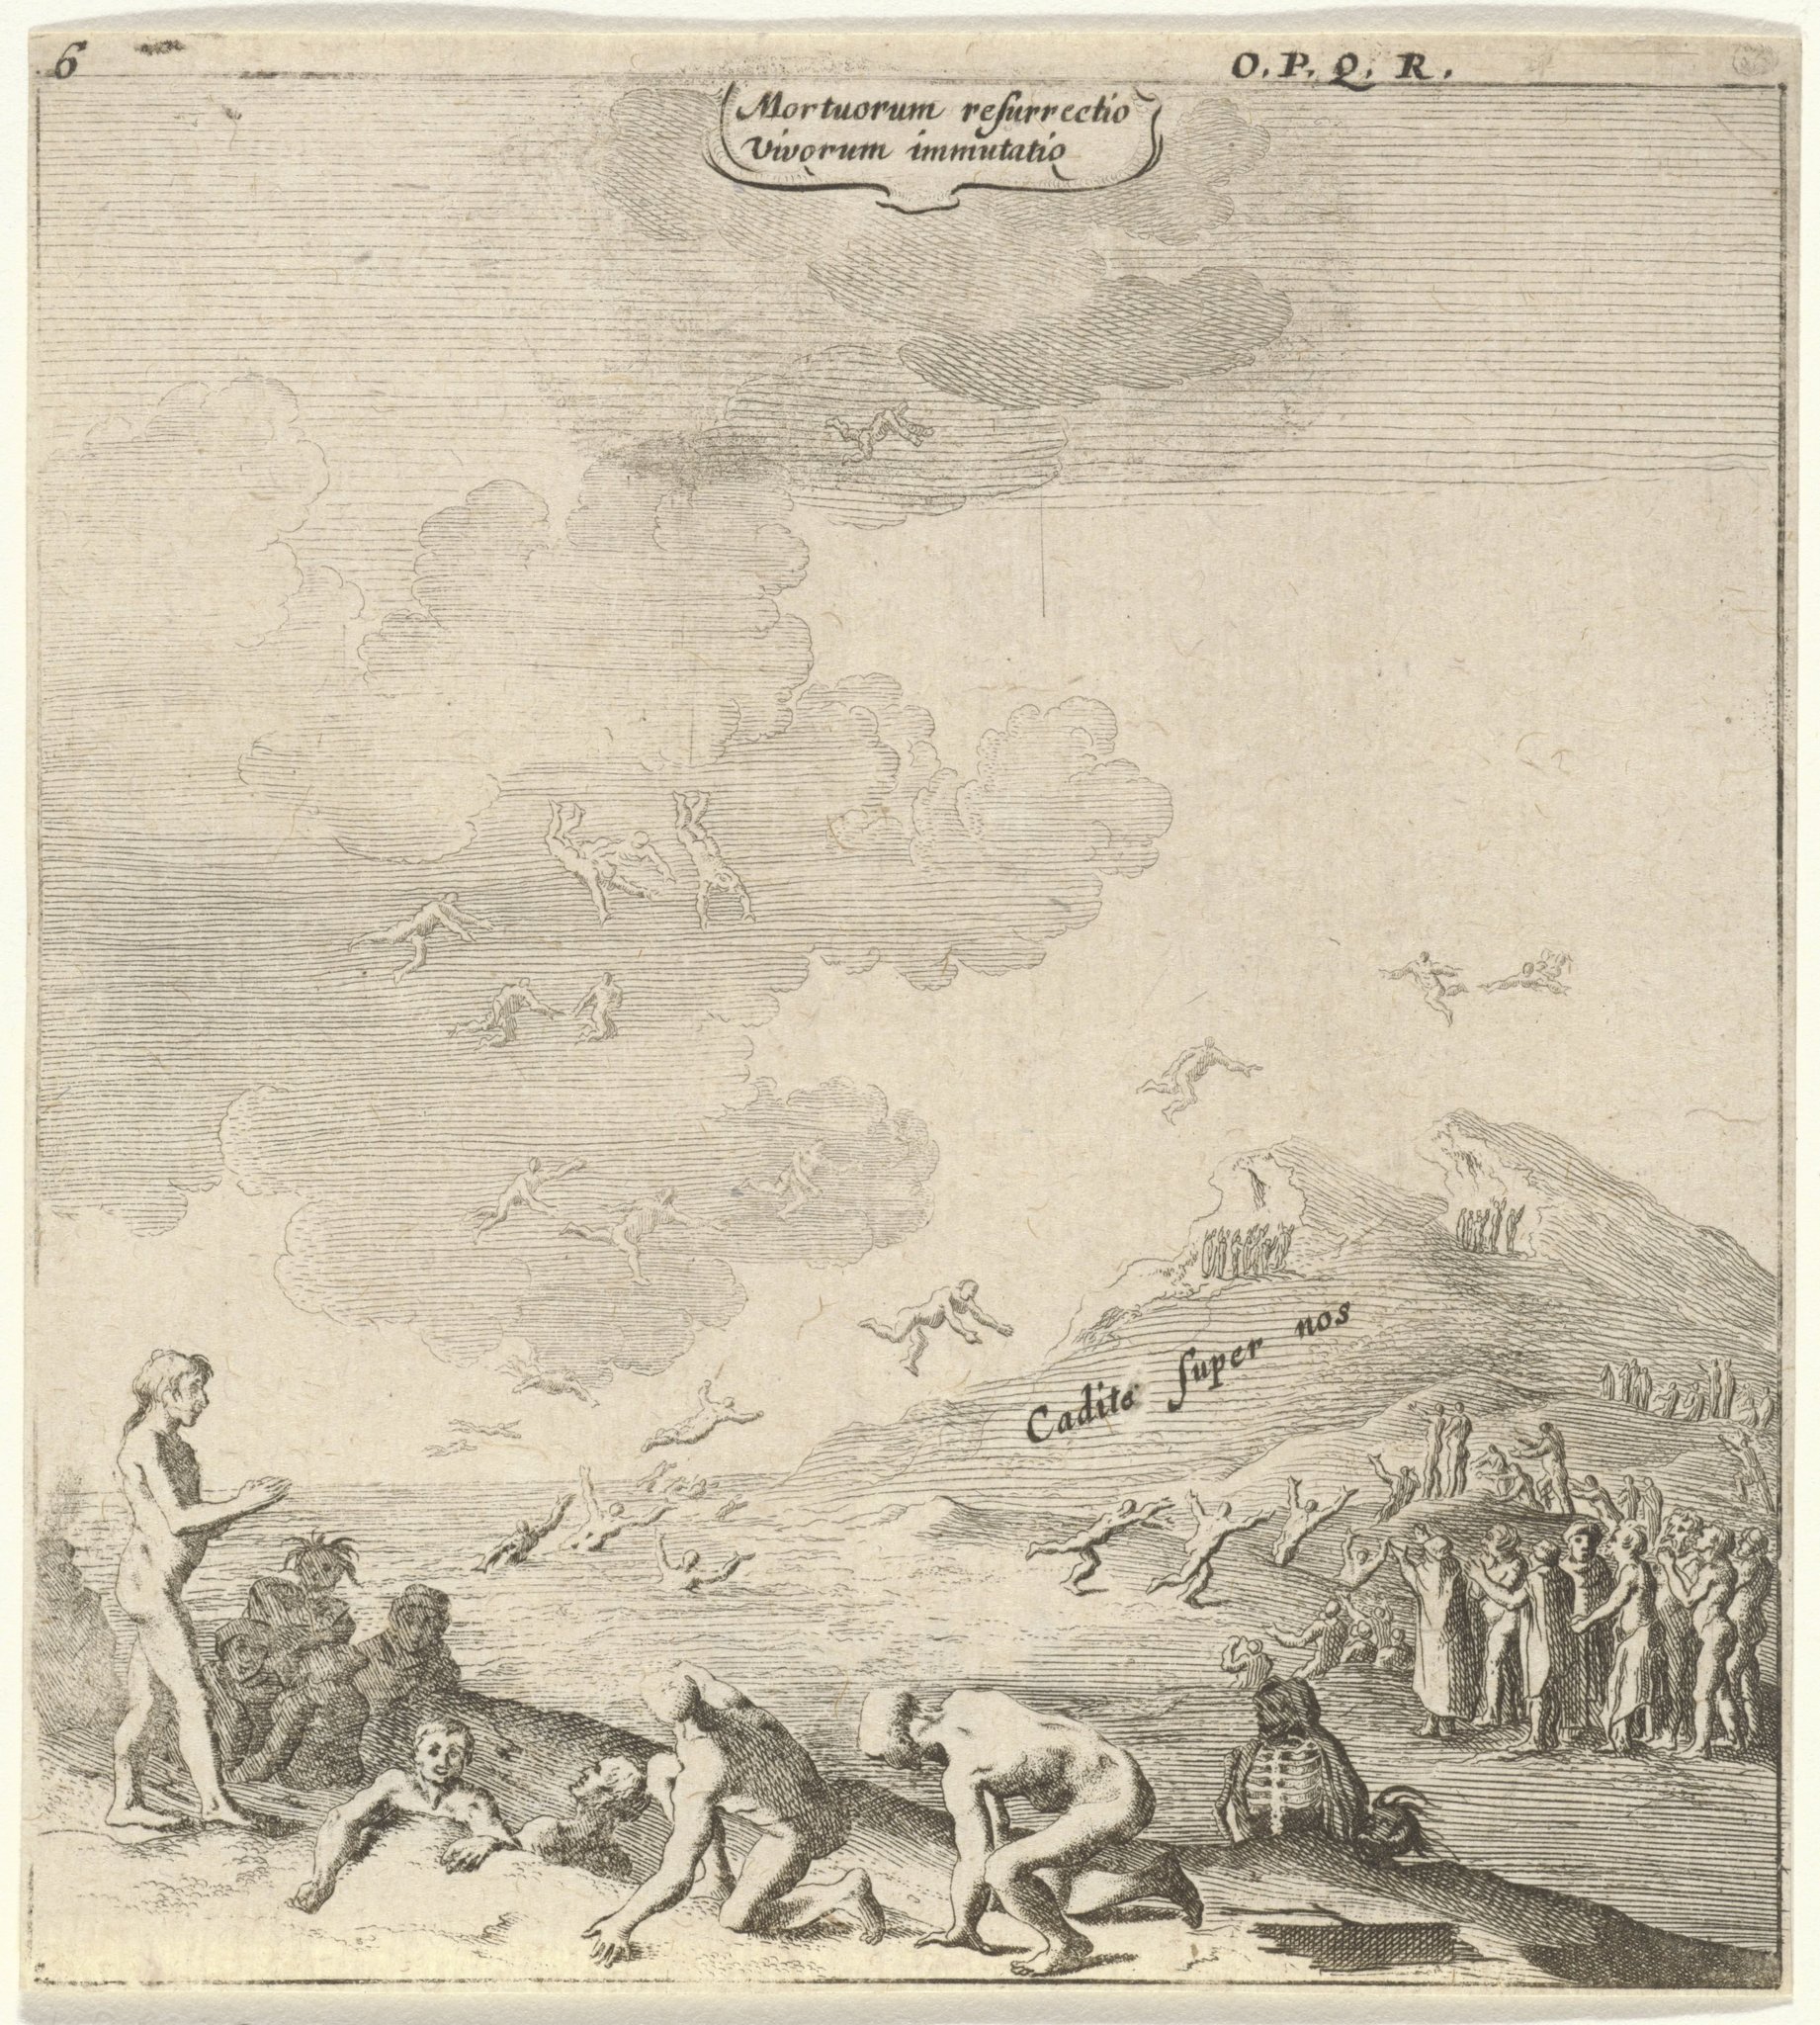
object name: book illustration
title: Opstanding van de doden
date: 1625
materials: paper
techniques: etching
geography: cleves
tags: resurrection of the dead ~ last judgement, 'carnis resurrectionem' ~ articles of faith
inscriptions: collector's mark: Lugt 2228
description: Illustratie in: Peil, Johann. Tabula processum seu ordinem ultimi divini et criminalis judicii exhibens. Kleef: Gerhardus Verstegen, 1625, p. 28.